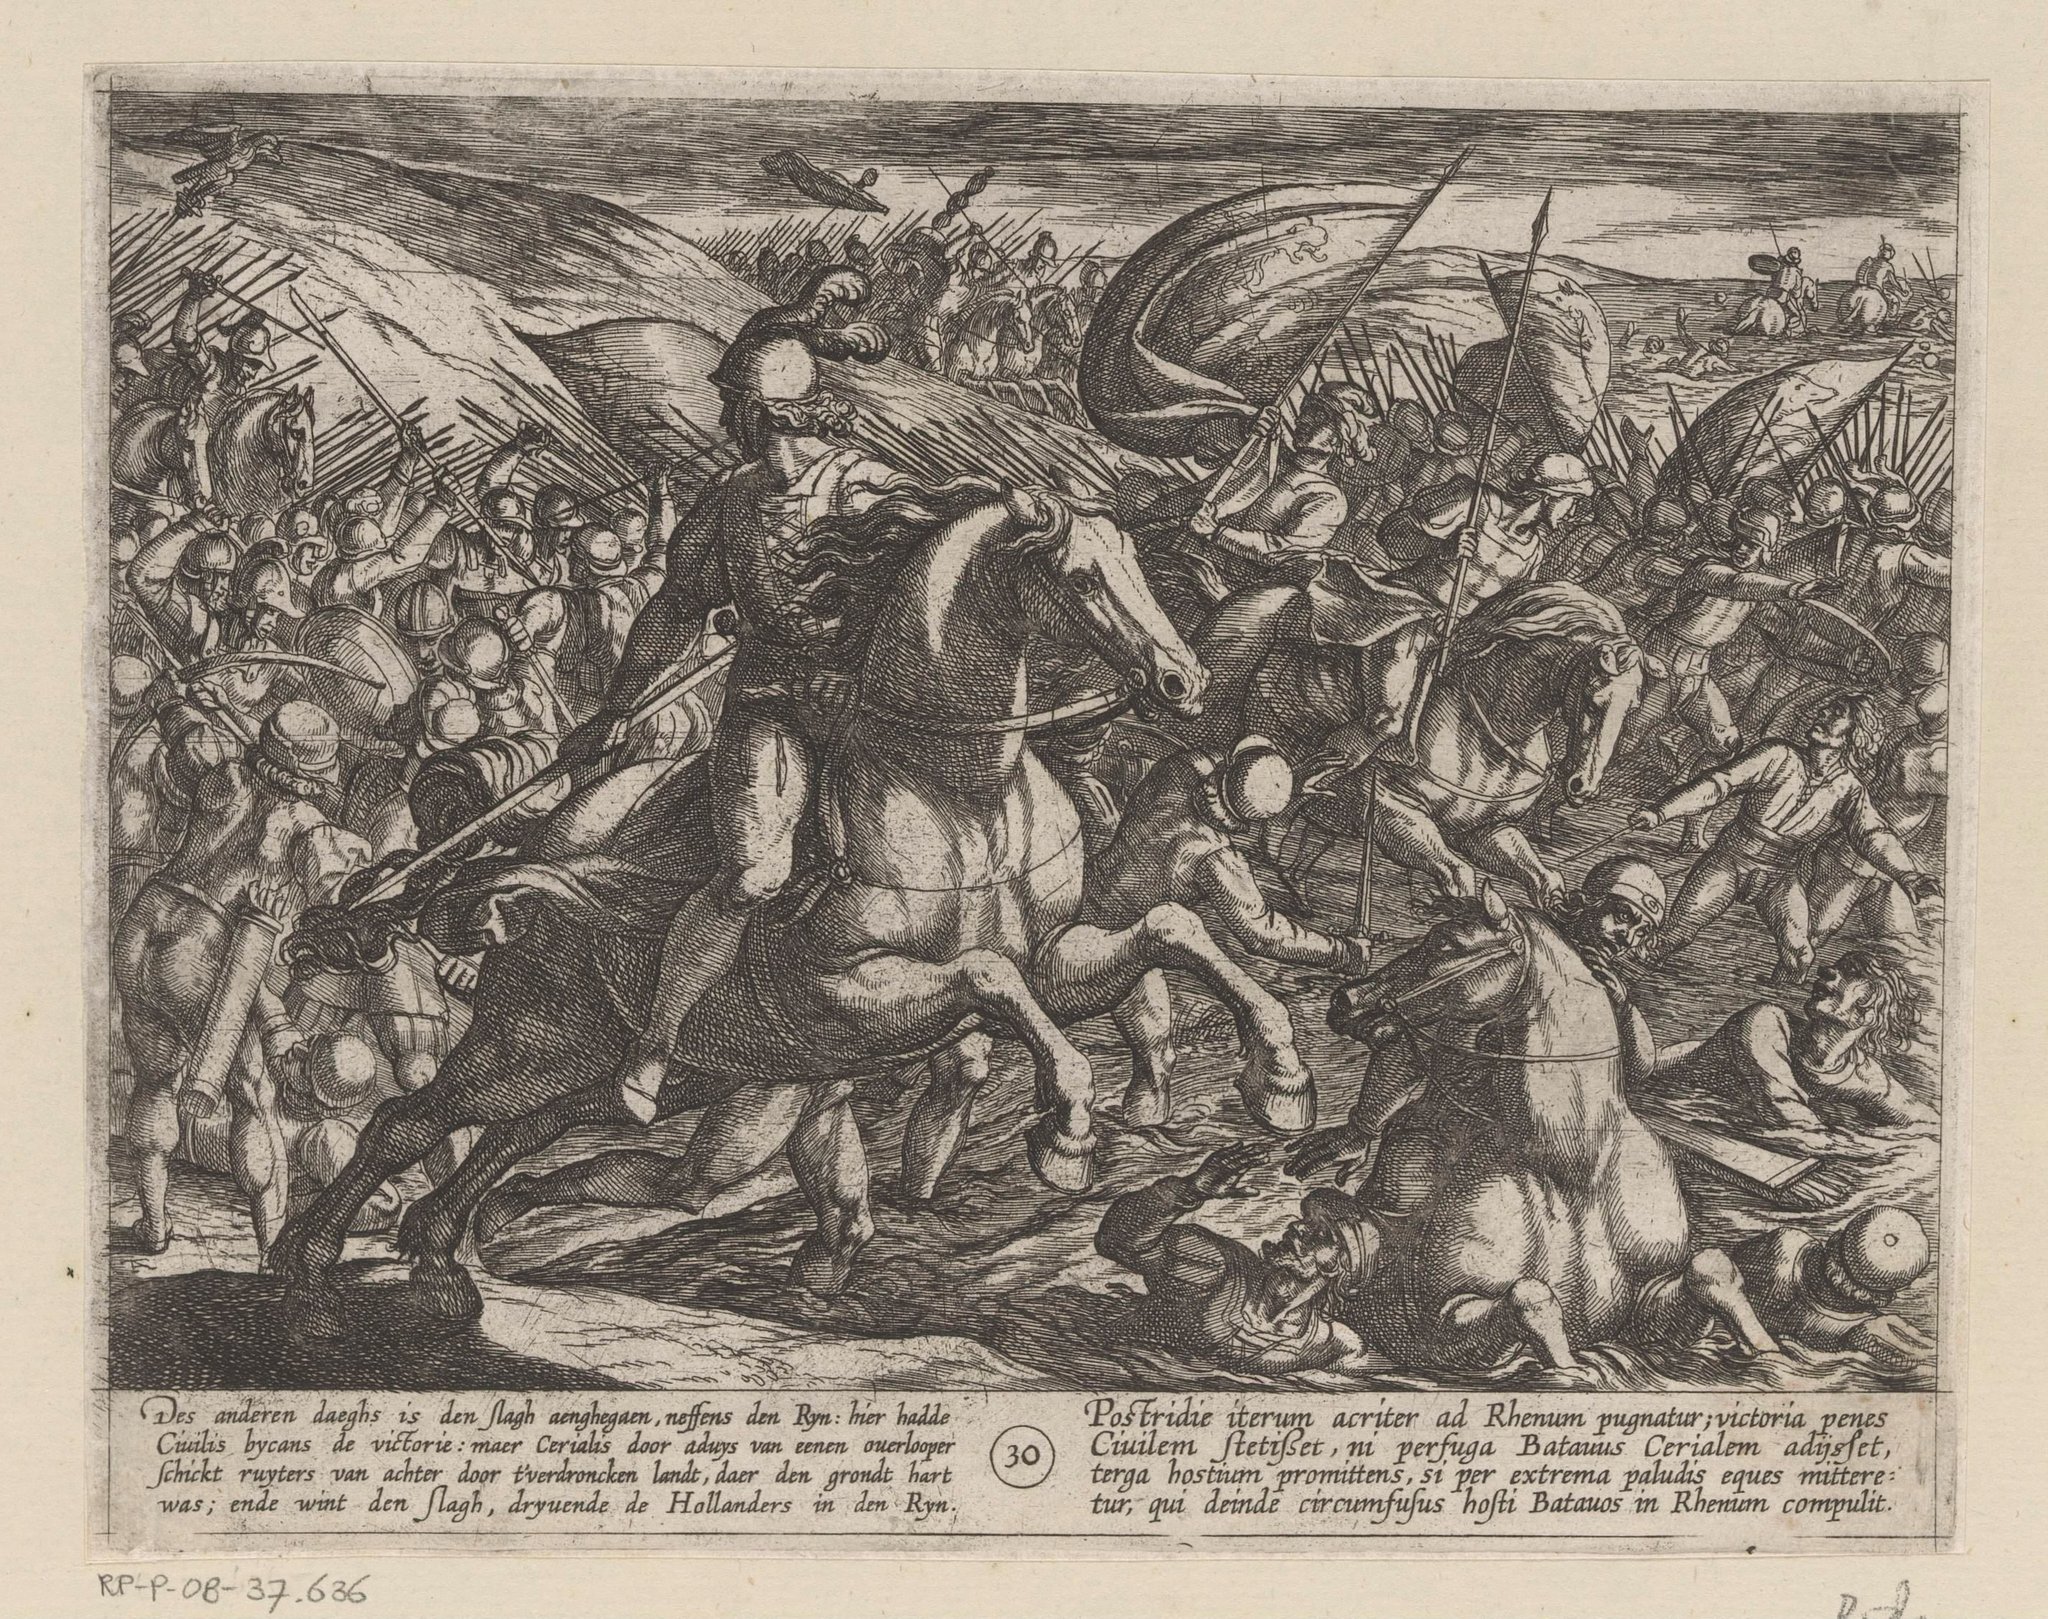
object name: print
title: De Bataafse oorlogen tegen de Romeinen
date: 1611-1612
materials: paper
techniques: etching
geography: italy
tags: battle, the soldier; the soldier's life, extinct, 'historical' peoples (with name)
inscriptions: collector's mark: Lugt 240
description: Cerialis en zijn Romeinse leger drijven de Nederlandse soldaten in de rivier de Rijn. Onderschrift in het Nederlands en in het Latijn.